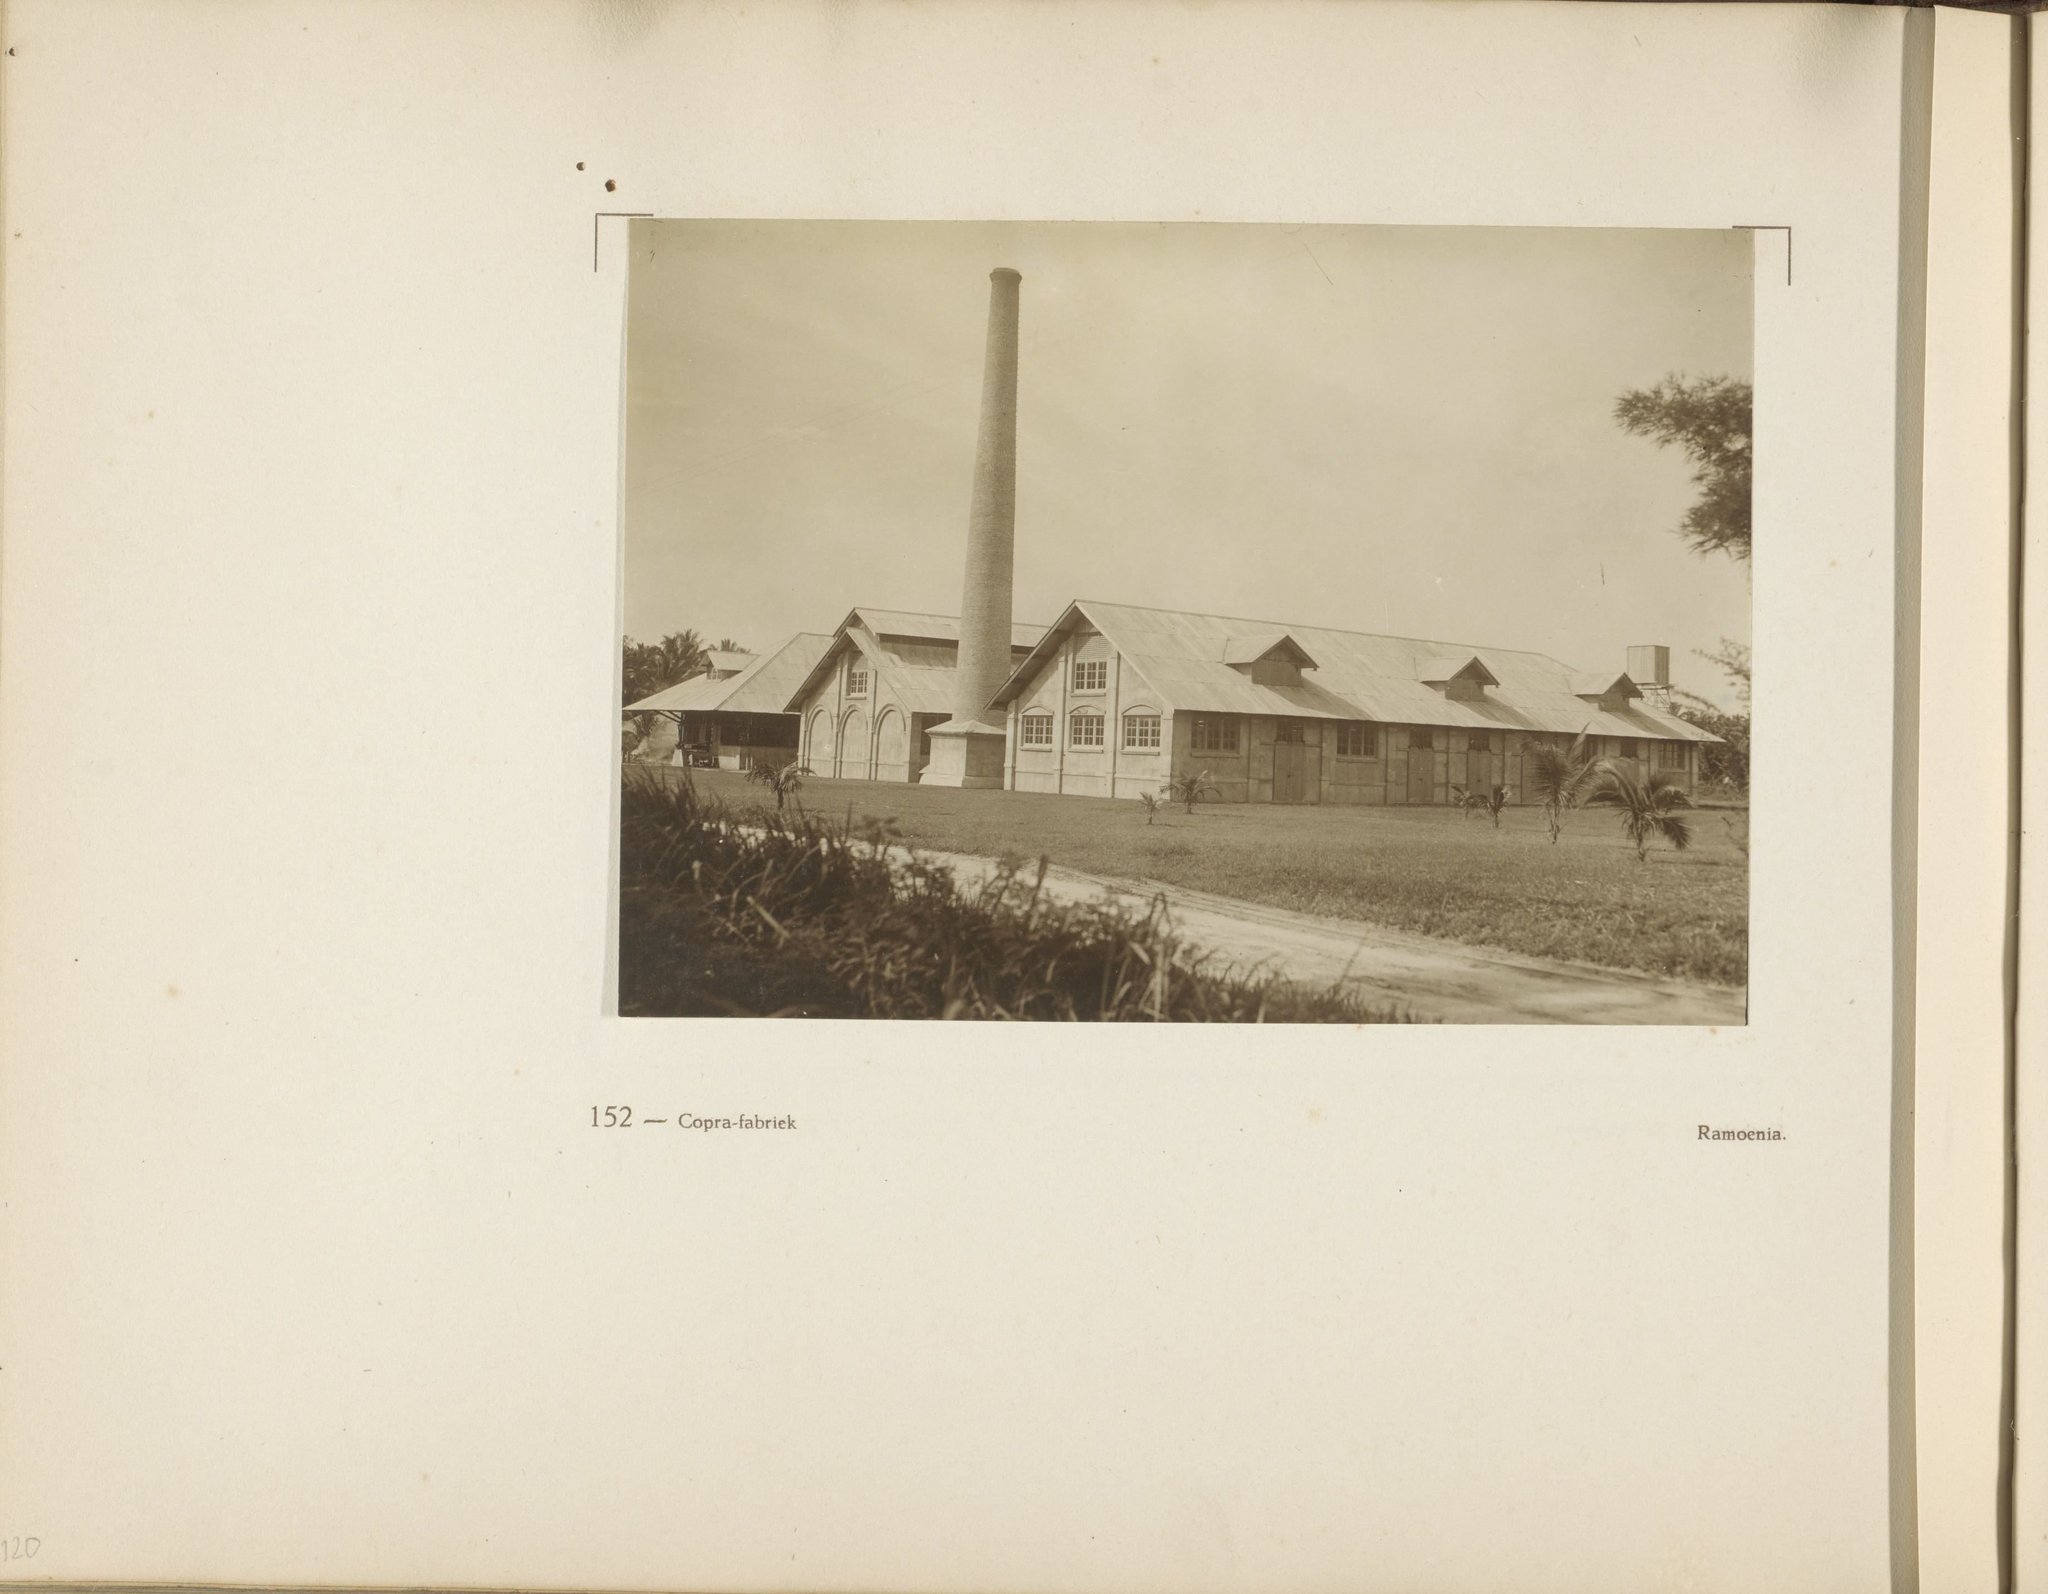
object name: photograph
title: Pagina 152 van fotoboek van de Algemeene Vereeniging van Rubberplanters ter Oostkust van Sumatra (A.V.R.O.S.)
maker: j.w. meyster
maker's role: fotograaf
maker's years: 1887-1945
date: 1924-1925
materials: paper, photographic support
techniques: printing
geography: sumatra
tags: factory-building, (non-fruit) products of plants or trees: rubber, trees: coconut-tree, sumatra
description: Boekpagina met een foto van het exterieur van een koprafabriek te Ramoenia. Onderdeel van een fotoboek van de Algemeene Vereeniging van Rubberplanters ter Oostkust van Sumatra (A.V.R.O.S.).